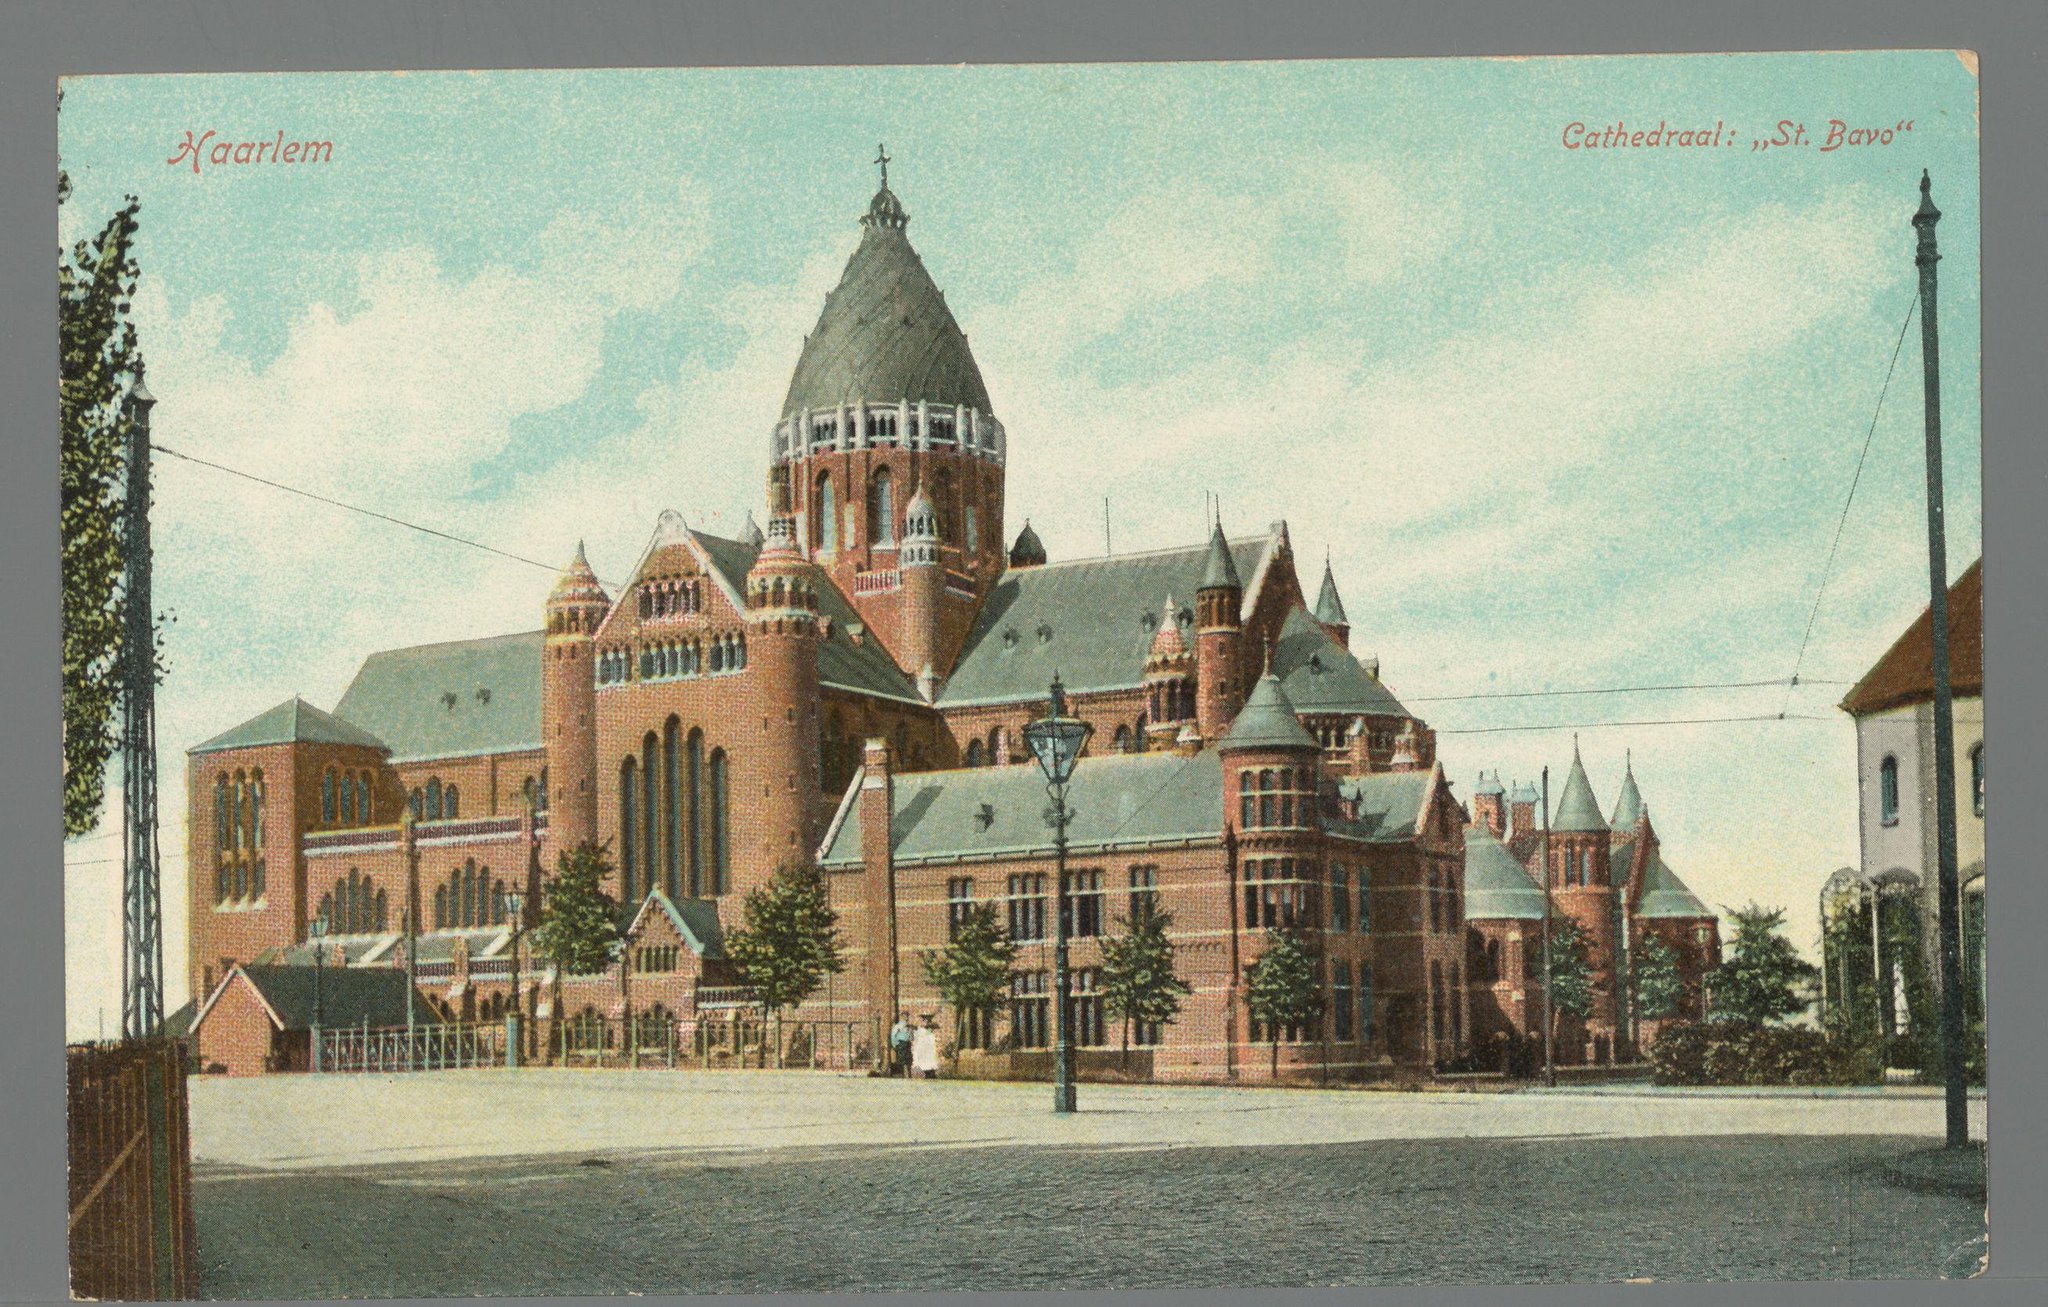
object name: ansichtkaart, prentbriefkaart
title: Haarlem. Cathedraal: "St. Bavo"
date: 1906-1930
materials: cardboard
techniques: lithograph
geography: amsterdam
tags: city-view, and landscape with man-made constructions, church (exterior), haarlem